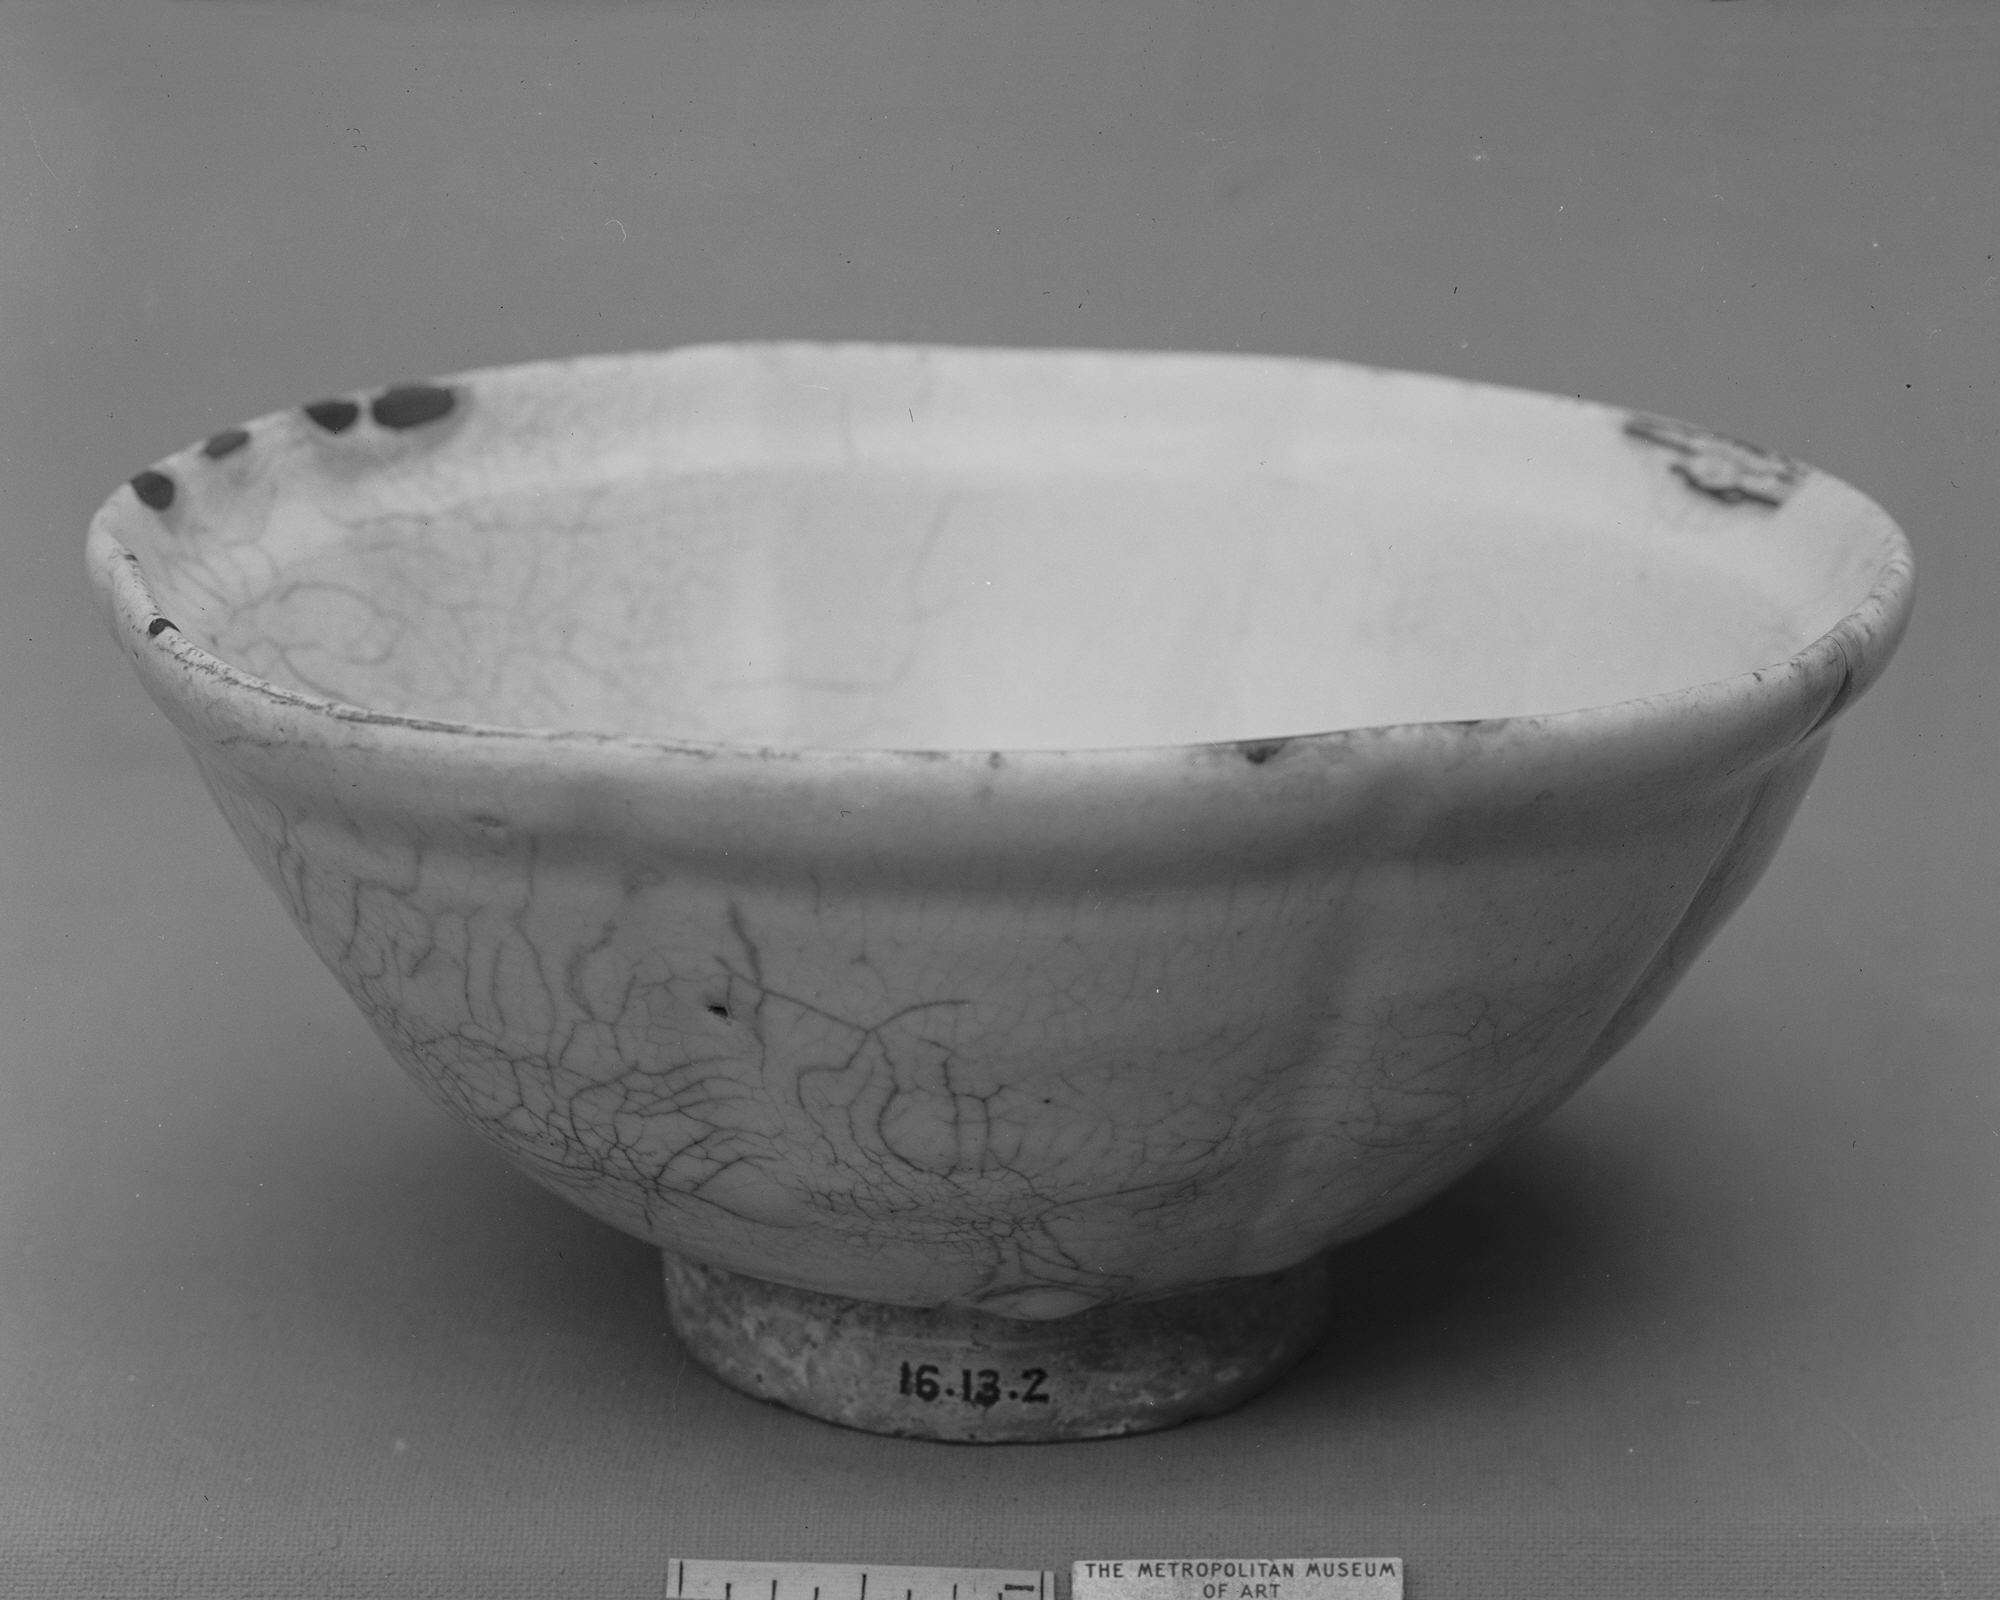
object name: bowl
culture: chinese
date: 960-1279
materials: pottery